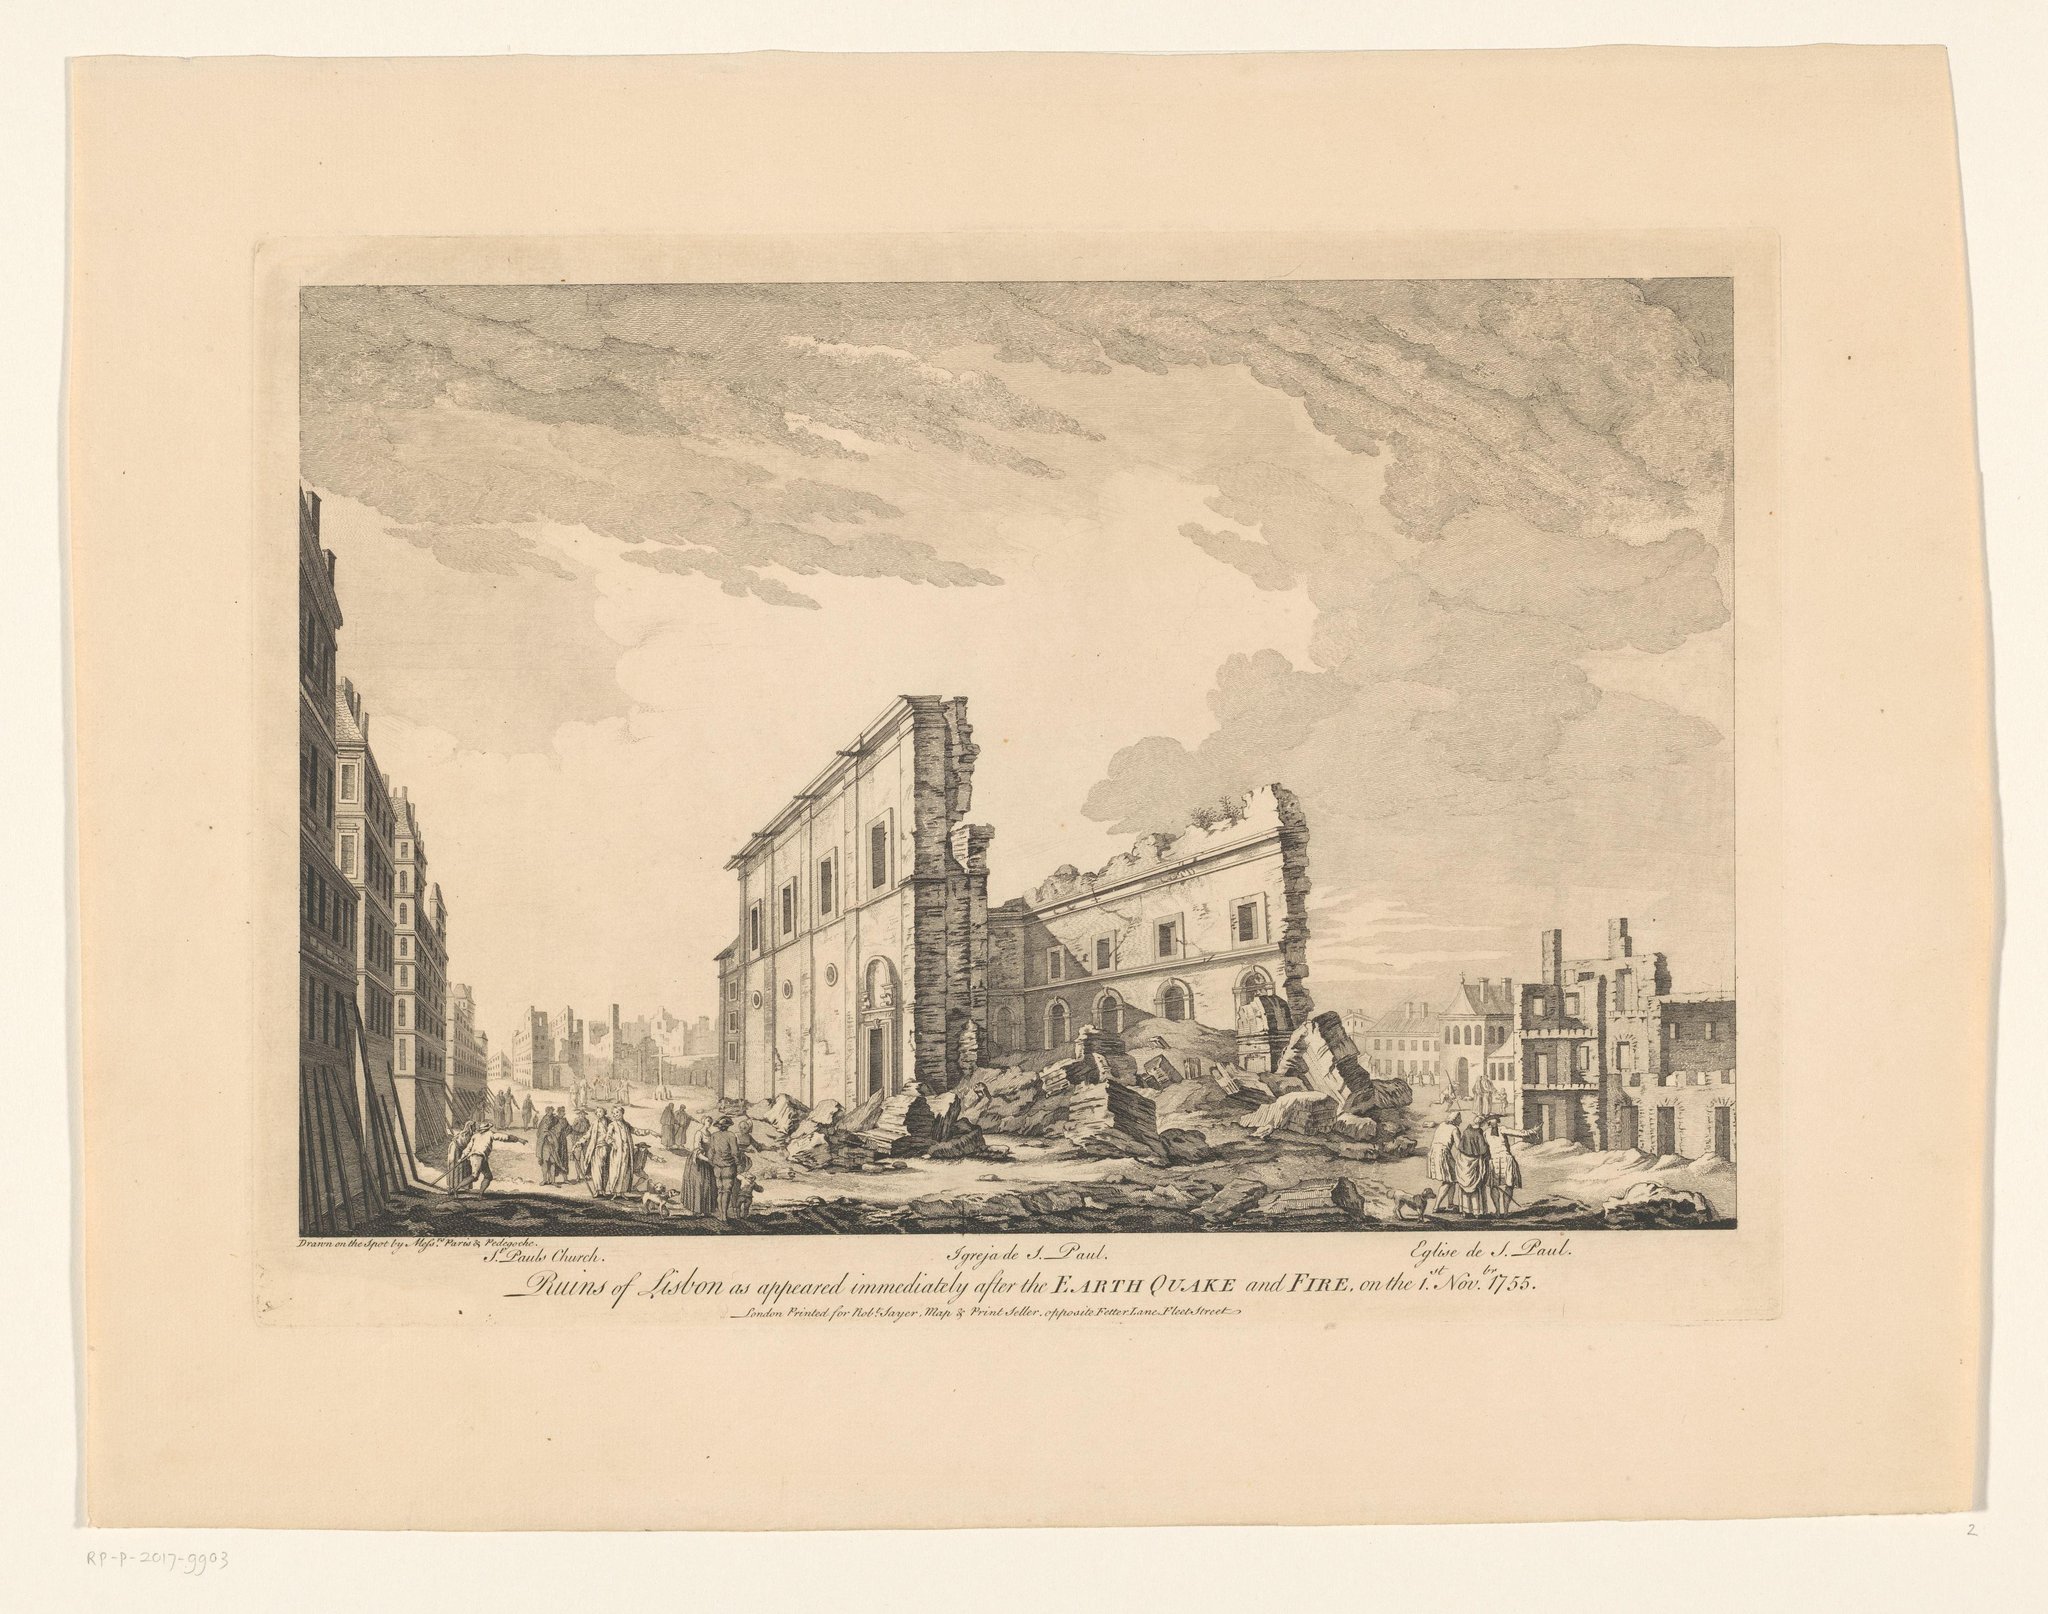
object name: print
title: St Paul's Church / Igreja de S. Paul / Eglise de S. Paul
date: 1758-1760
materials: paper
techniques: etching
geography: london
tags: ruin of a building ~ architecture, consequences of an earthquake, ruin of church, monastery, etc.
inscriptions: collector's mark: Lugt 2228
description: Ruïne van Pauluskerk in Lissabon. Onderdeel van een serie van zes prenten van de ruïnes van de stad Lissabon na de grote aardbeving van 1 november 1755. Kopieën naar de oorspronkelijke prentserie door J.P. Le Bas van 1758, naar tekeningen van lokale kunstenaars, waarschijnlijk amateurs, aangeduid als Paris & Pedegoche.